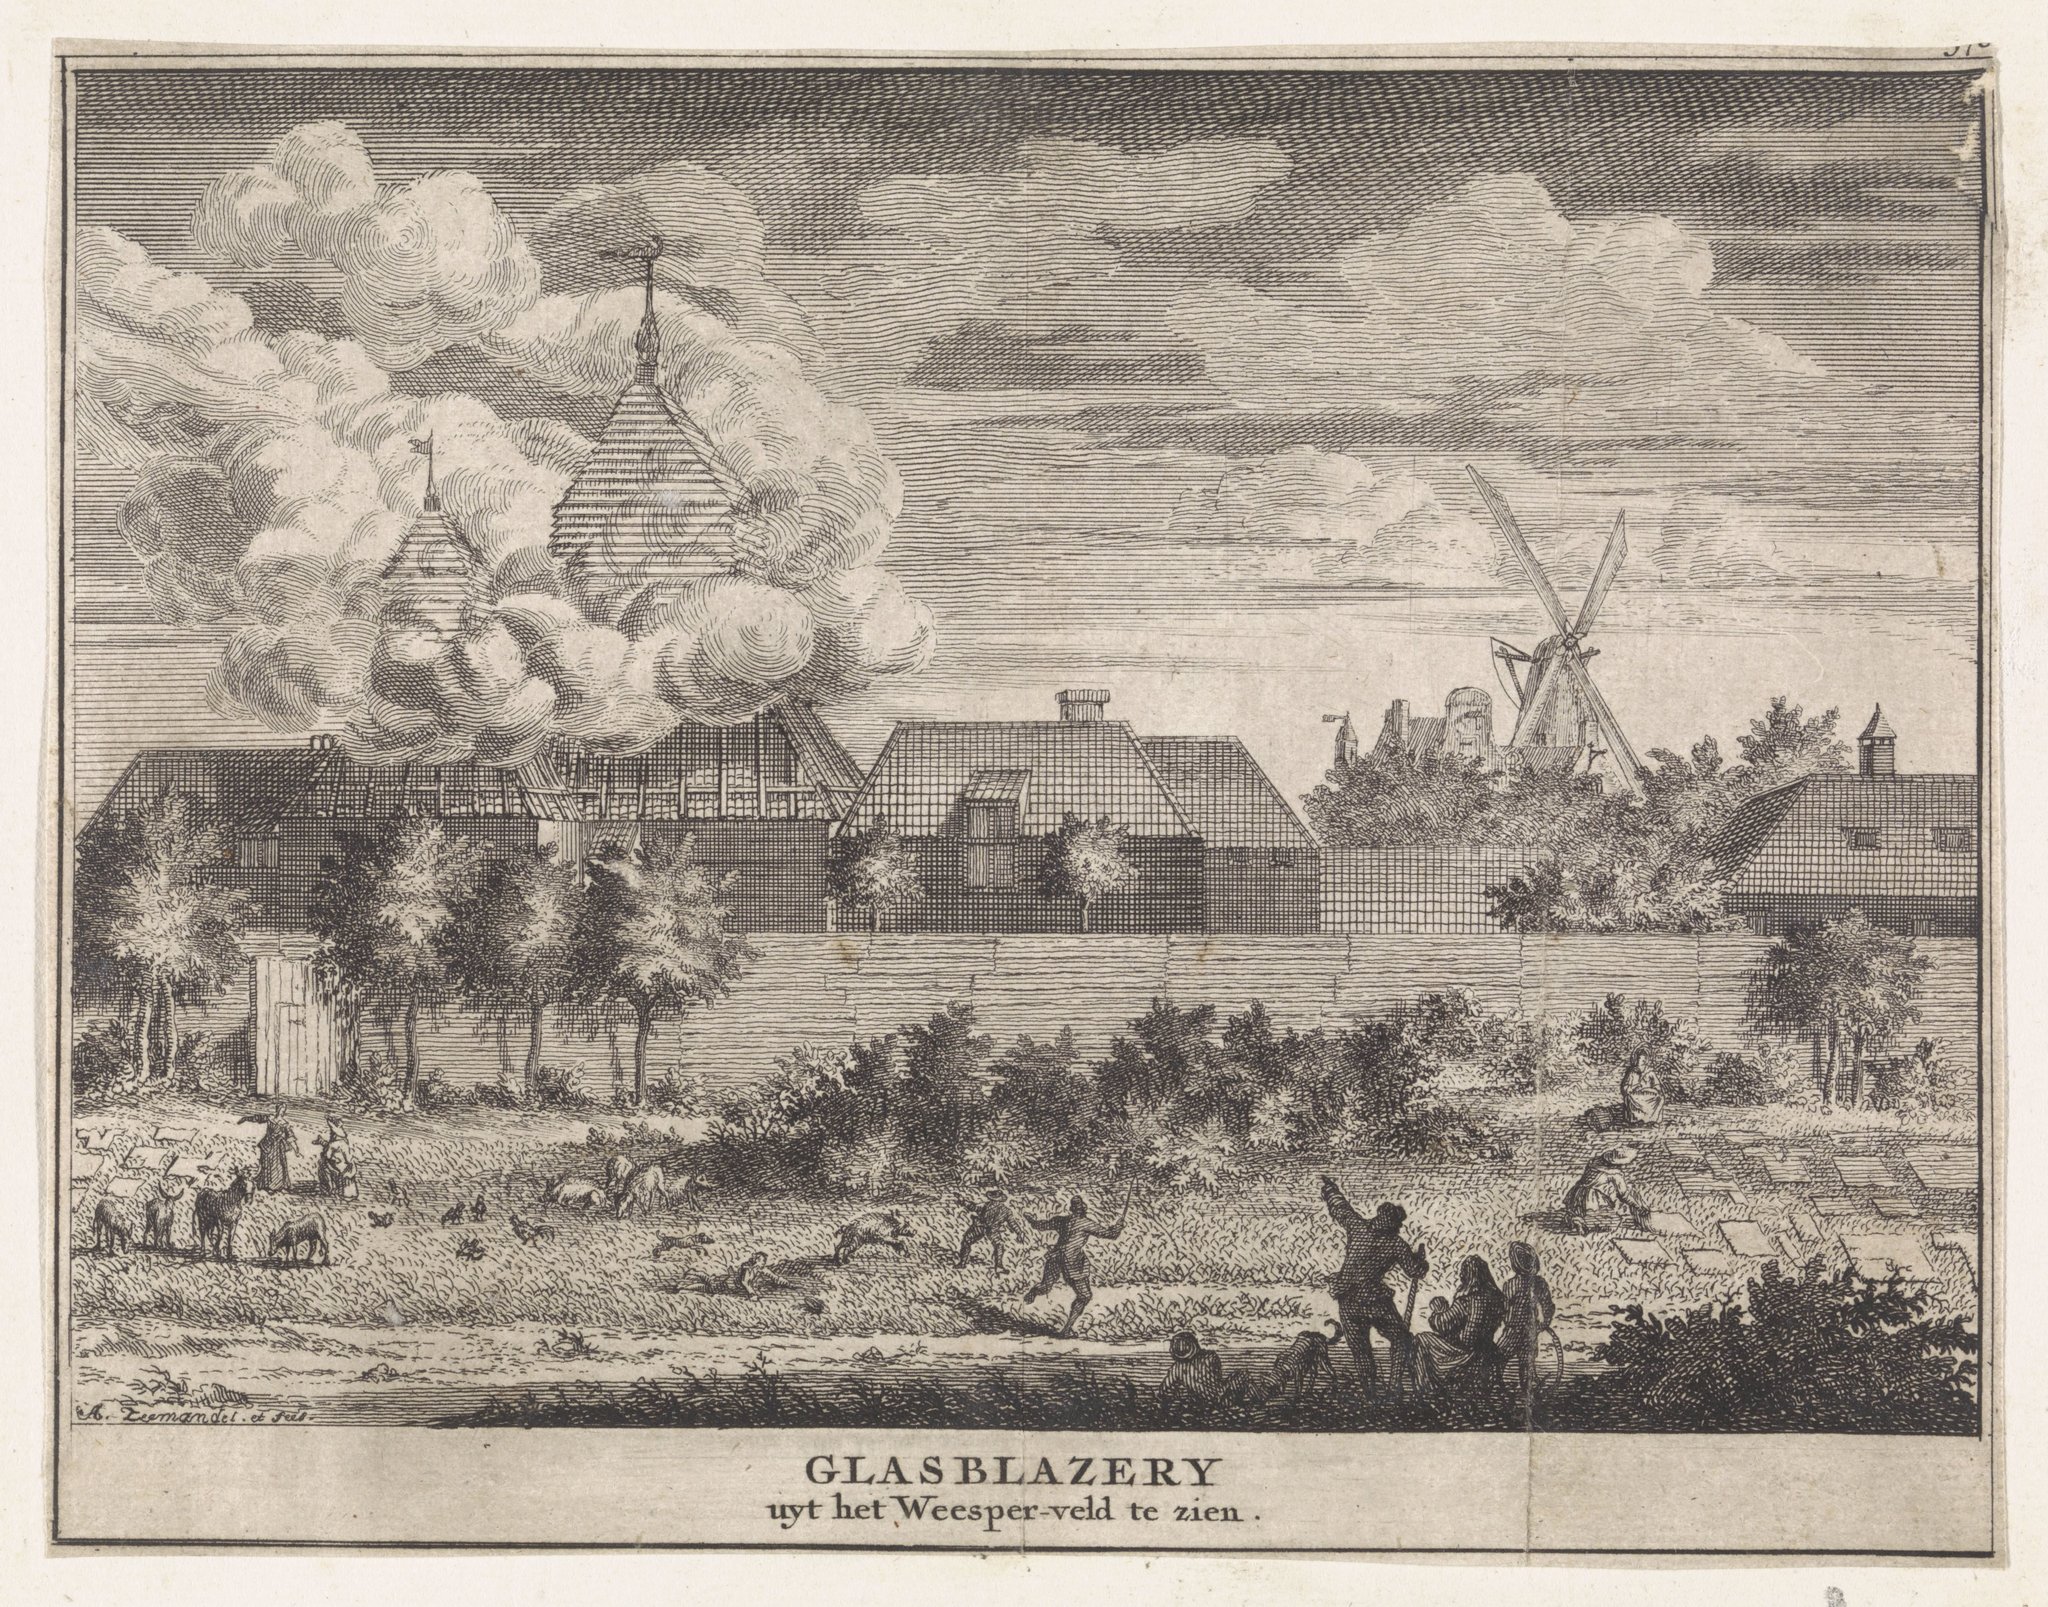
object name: print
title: Gezicht op de glasblazerij op het Roeterseiland te Amsterdam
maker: abraham zeeman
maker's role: print maker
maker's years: 1695-1754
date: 1726-1737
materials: paper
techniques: engraving, etching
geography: amsterdam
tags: glass industry, bleaching (laundering)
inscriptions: collector's mark: Lugt 2233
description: Huidige staat van prent mogelijk ook gebruikt in: Hoorn, Nicolaas ten. Wegwyzer door Amsterdam, Zynde eene beknopte verhandeling van desselfs eerste opkomst, vergrootingen, en teegenwoordigen staat (…). Amsterdam: Nicolaas ten Hoorn, 1726. En in: Hoorn, Nicolaas ten. Wegwyzer, of korte beschryvinge Van de Stadt Amsterdam, Zynde eene beknopte Verhandeling van desselfs eerste opkomst, vergrootingen, en tegenwoordigen staat (…). Amsterdam: erven J. Ratelband & Co, 1737. Latere staat van prent ook gebruikt in: Hoorn, Nicolaas ten. Wegwyzer of korte beschryvinge der stad Amsterdam. Zynde eene Beknopte Verhandeling van derzelver eerste Opkomst, Vergrootingen en Tegenwoordigen Staat (…). Amsterdam: Pieter Meyer, 1751. Voor eerste staat zie RP-P-AO-25-71-1. Voor derde staat zie RP-P-AO-25-71-2 en RP-P-1905-4060.